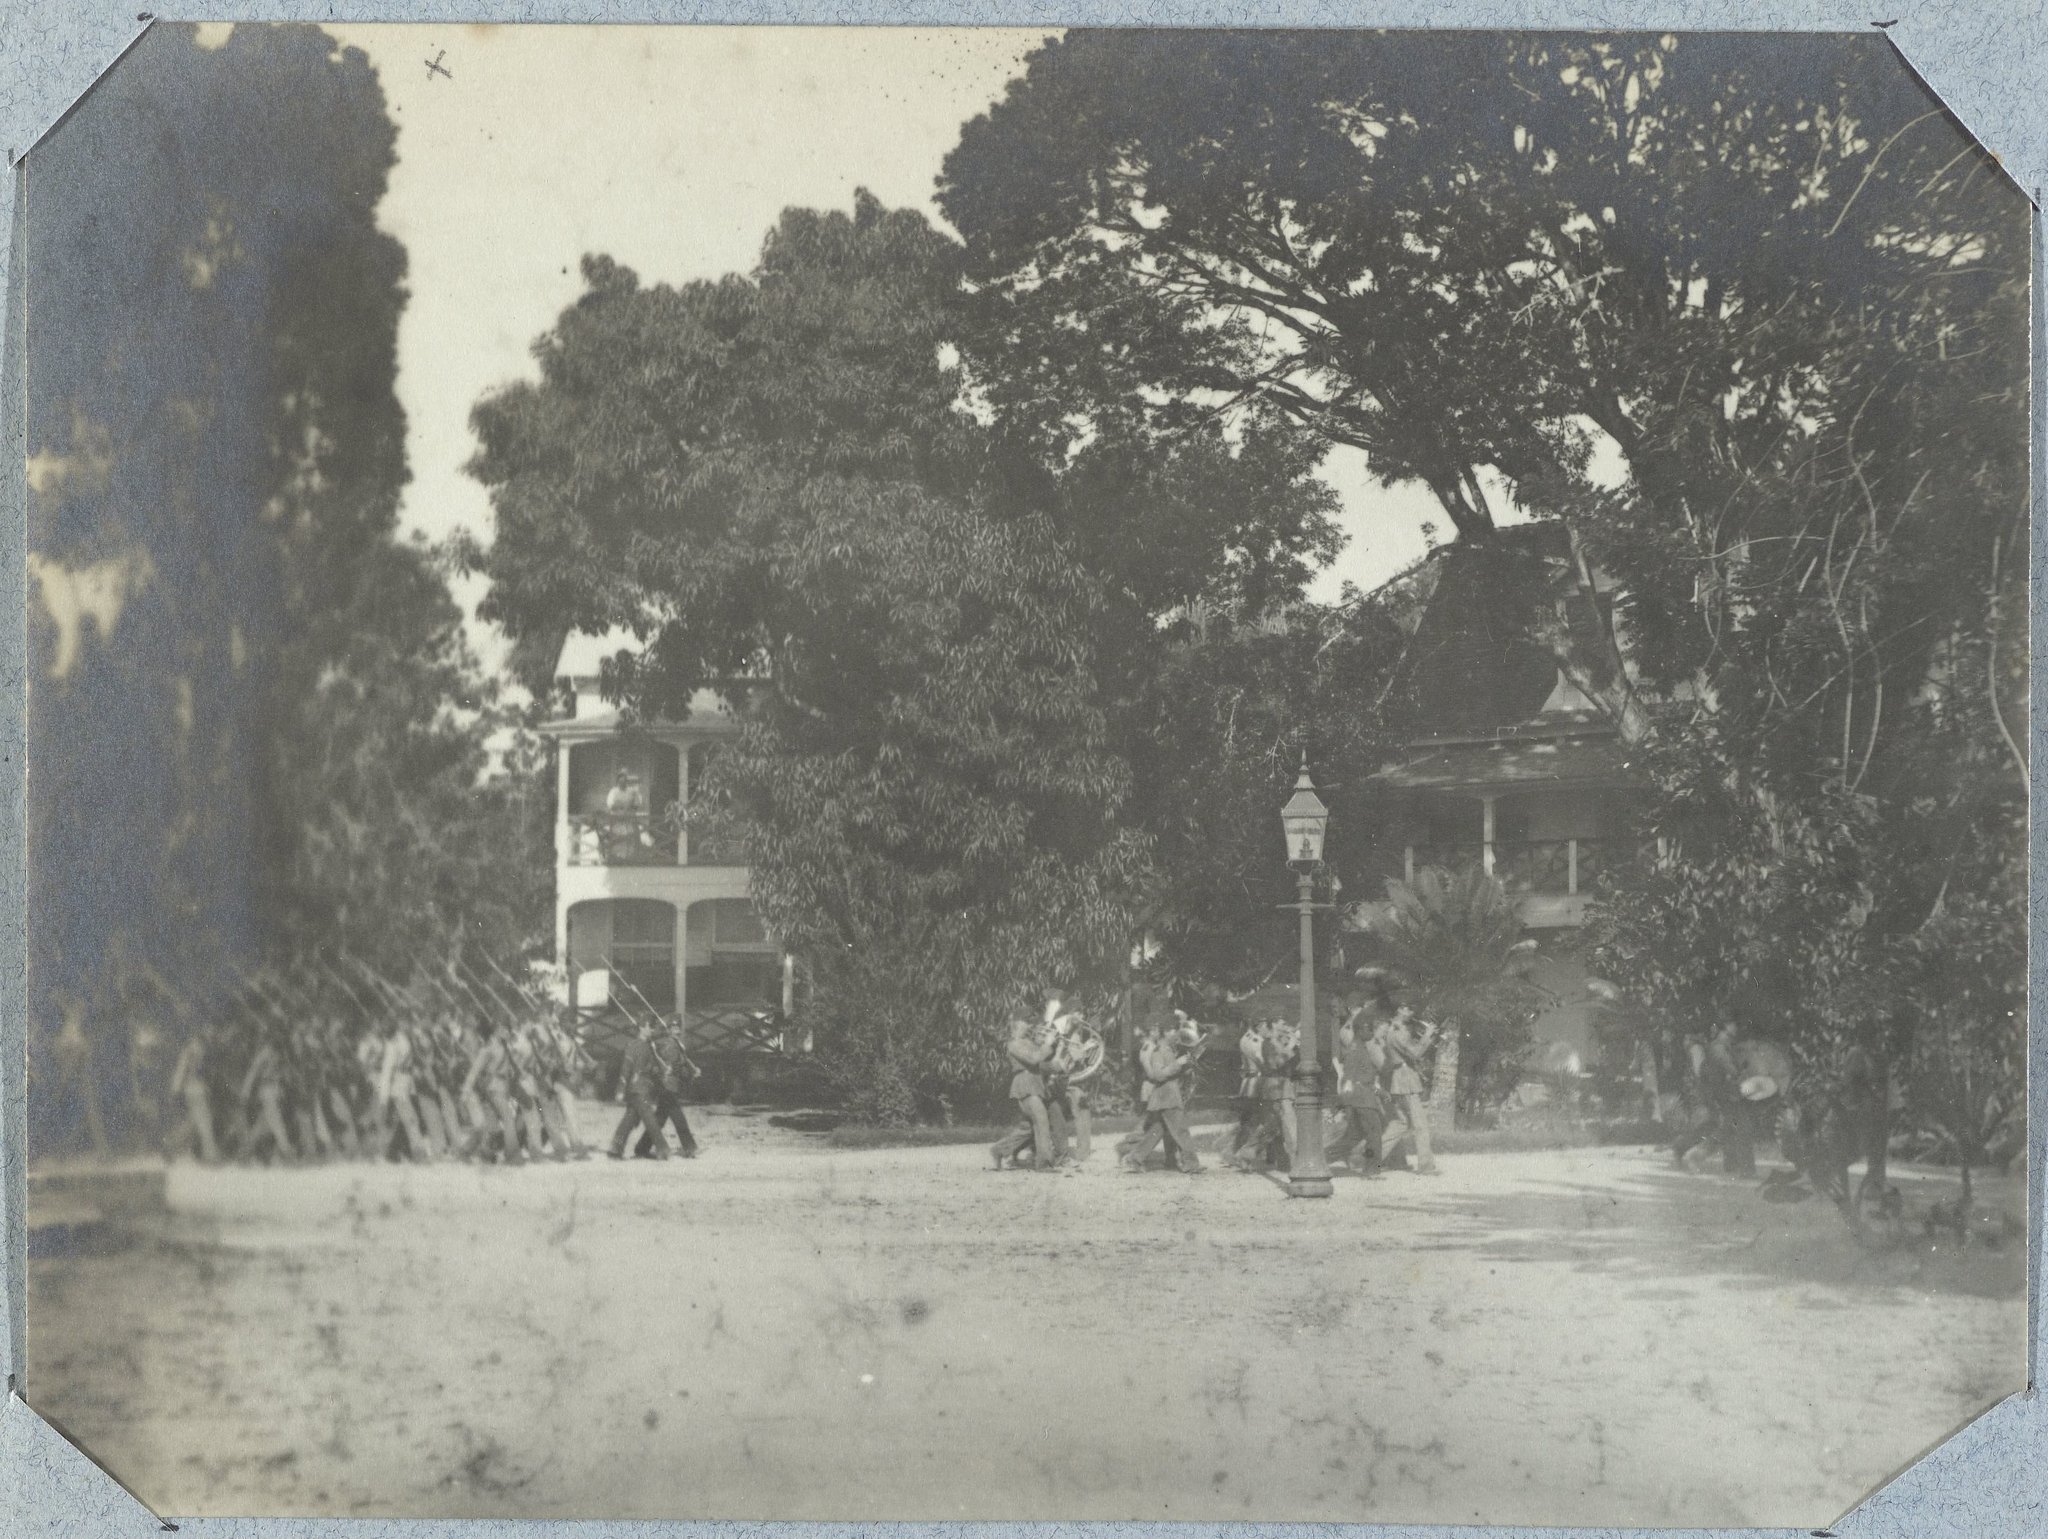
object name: photograph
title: Officierswoningen in het Fort "Zeelandia"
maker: théodore van lelyveld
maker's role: painter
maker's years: 1867-1954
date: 1896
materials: photographic support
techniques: gelatin silver print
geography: suriname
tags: garrison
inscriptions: inscription: ‘Officierswoningen in het Fort "Zeelandia"’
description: Gezicht binnen Fort Zeelandia te Paramaribo. Paraderende militairen voorafgegaan door een muziekkorps, op de achtergrond officierswongen. Fotoafdruk in een fotoalbum van Théodore van Lelyveld over Suriname uit 1895-1898.